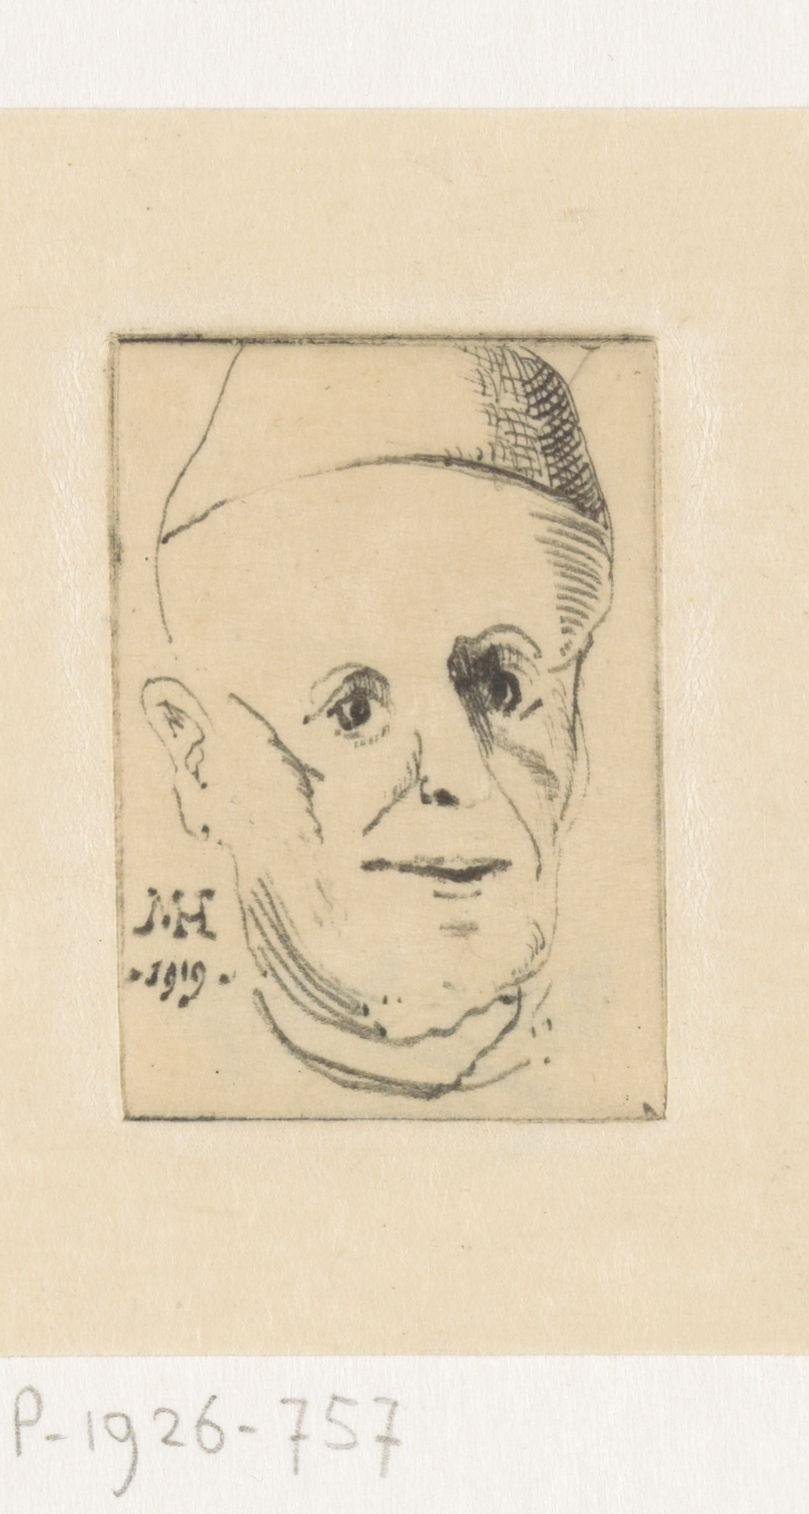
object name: print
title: Oude man met muts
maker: marius holleman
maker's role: draughtsman, print maker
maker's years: 1878-1926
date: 1919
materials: paper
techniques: etching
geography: groningen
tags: old man, head-gear: hat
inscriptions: collector's mark: Lugt 2228